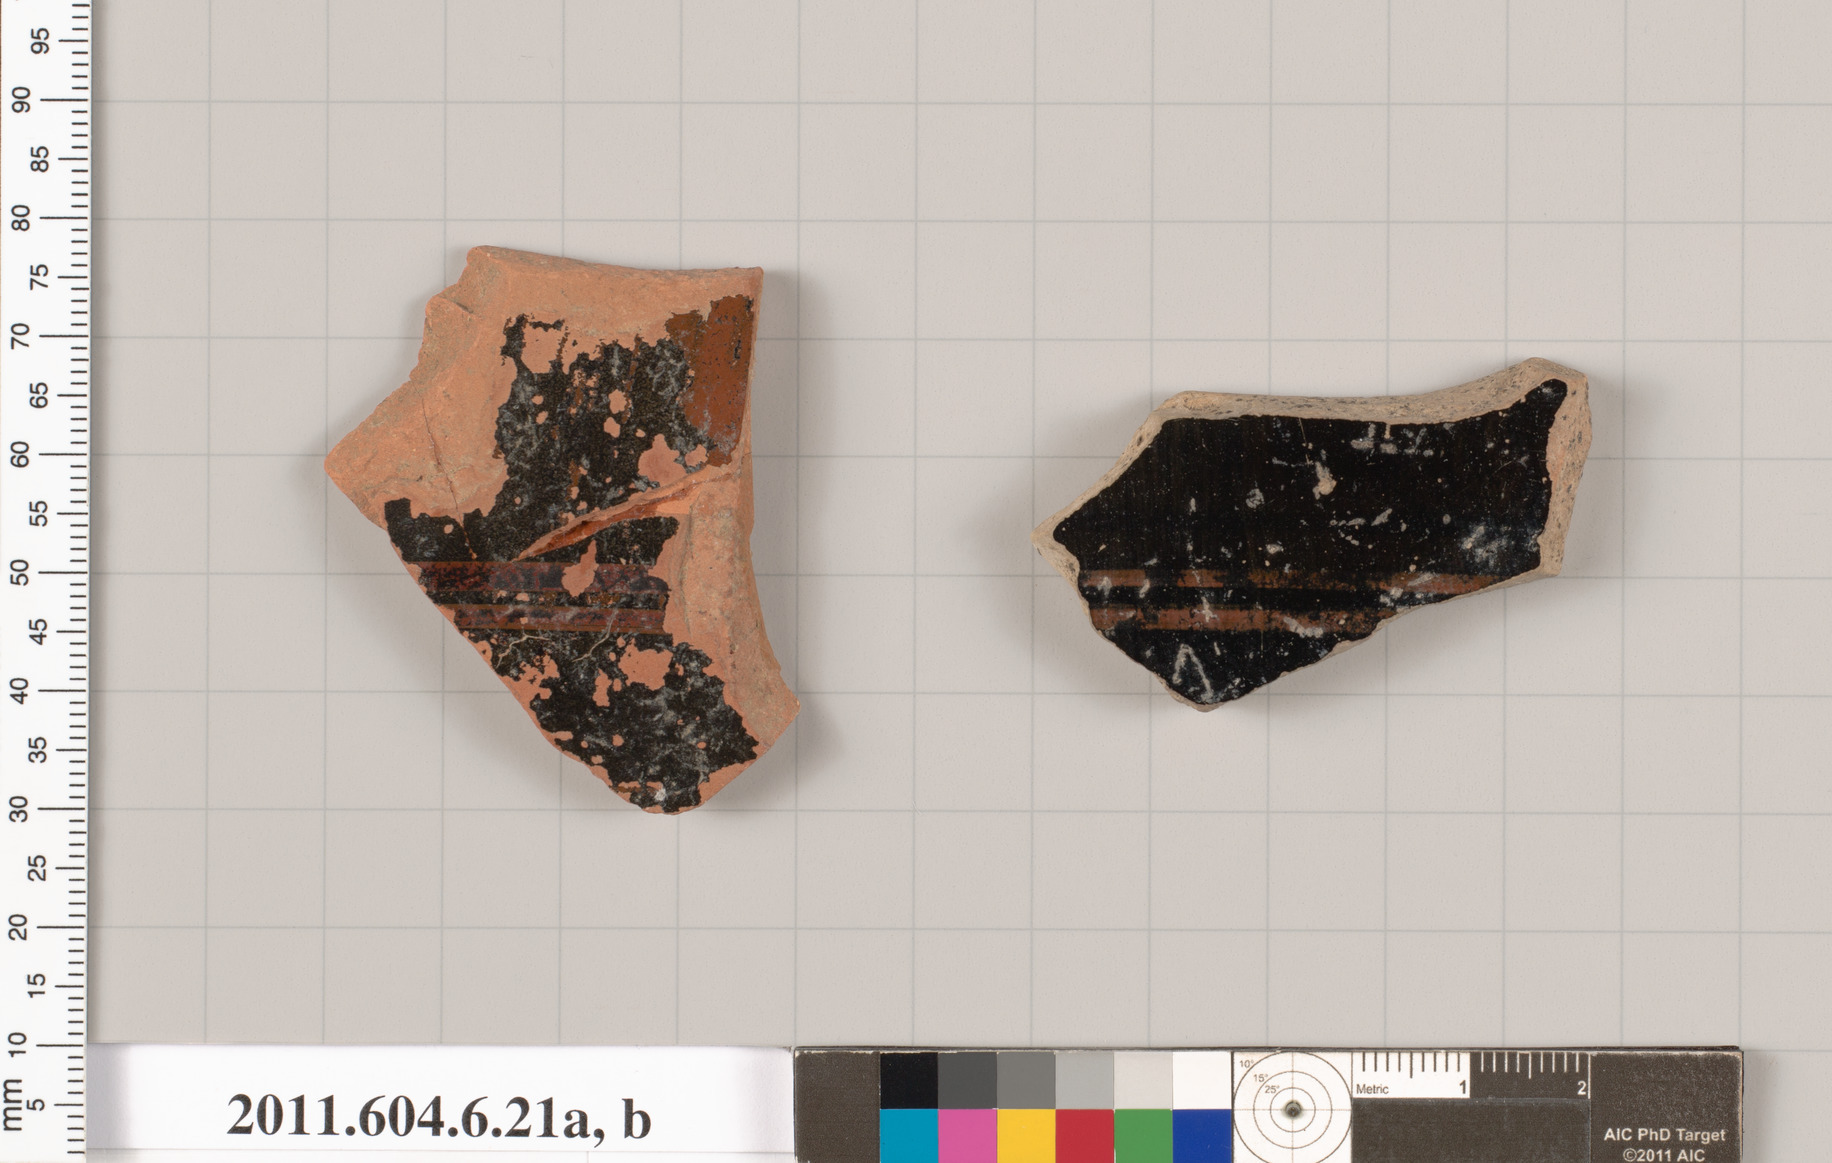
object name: undetermined closed shape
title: Terracotta fragments of closed shapes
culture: greek, attic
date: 600-401 BCE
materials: terracotta